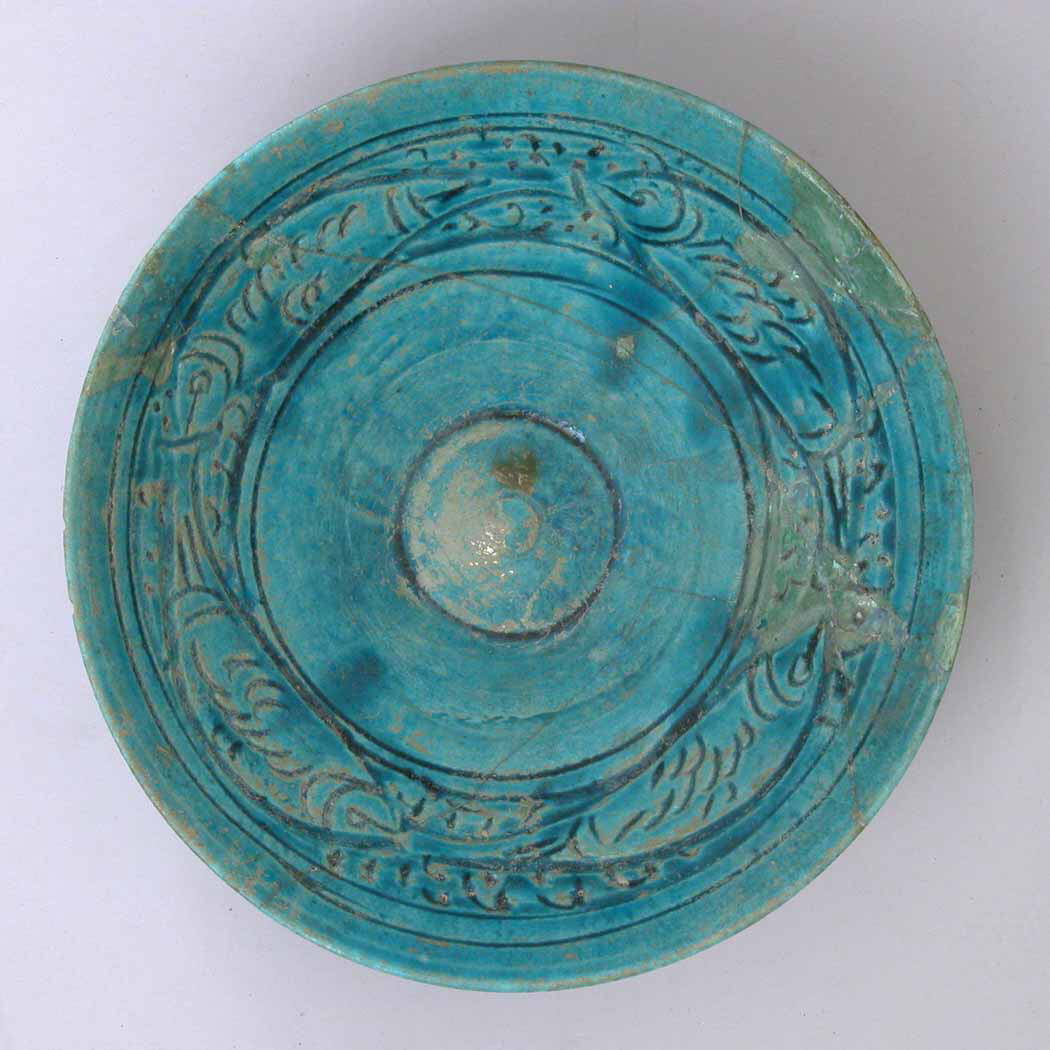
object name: bowl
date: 1101-1300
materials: stonepaste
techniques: glazing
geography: iran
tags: fish